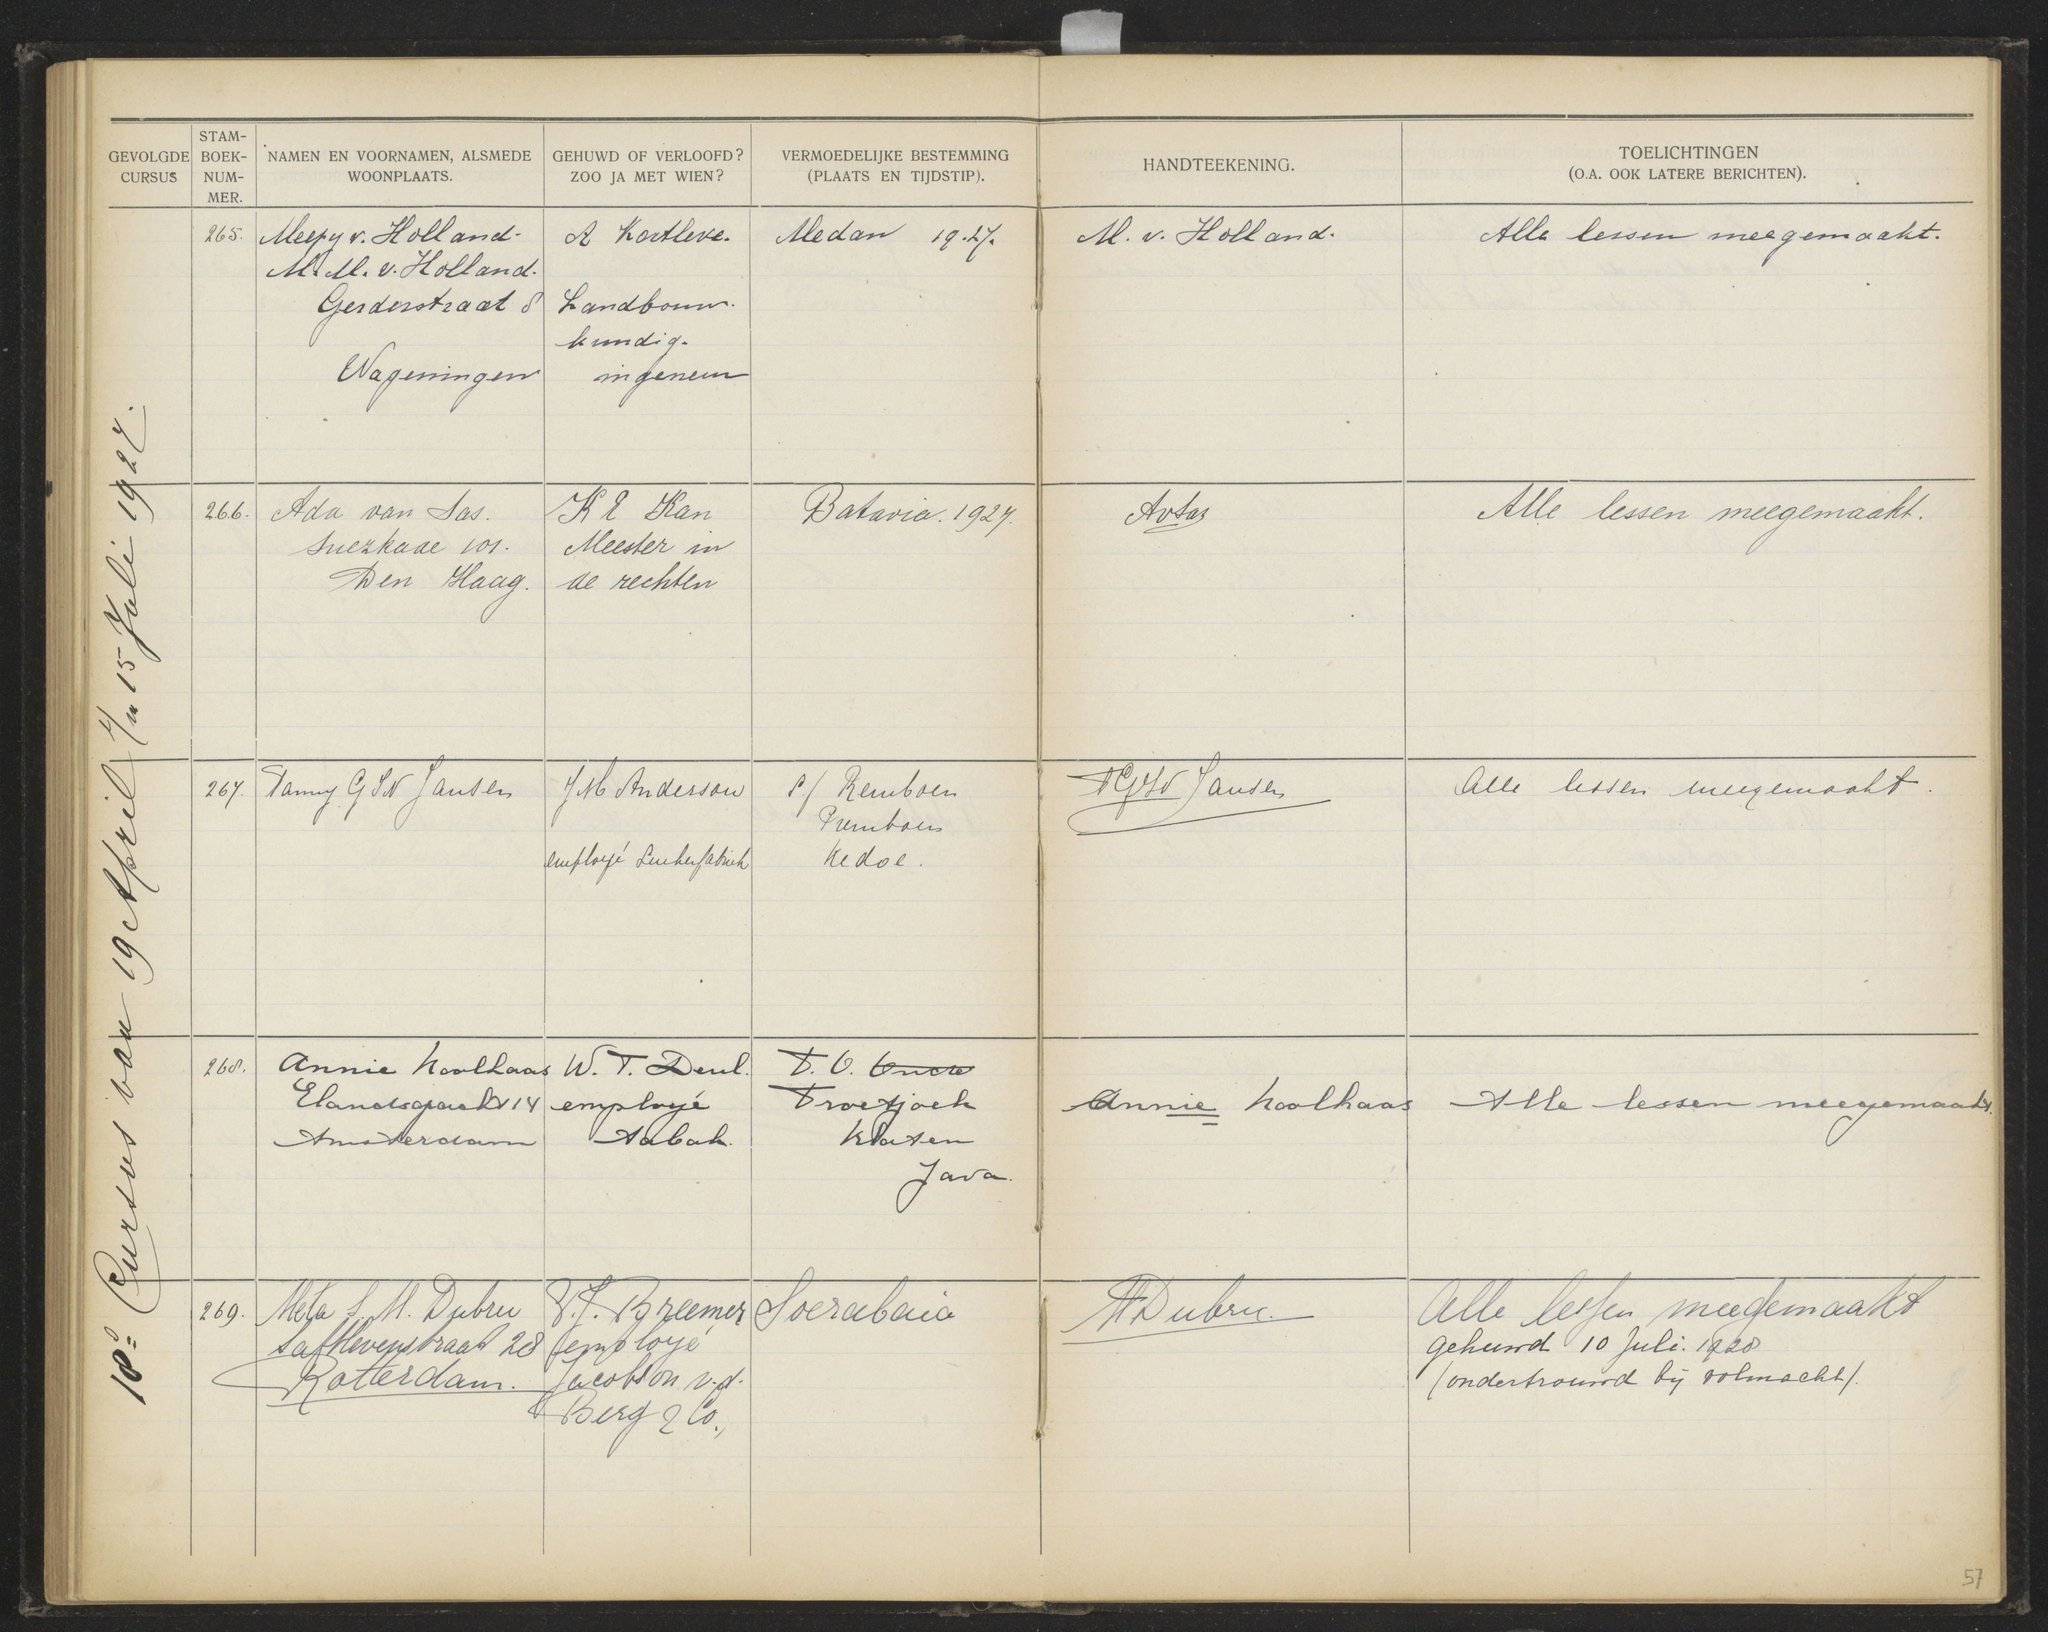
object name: album leaf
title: Blad 57 uit Stamboek van de leerlingen der Koloniale School voor Meisjes en Vrouwen te 's-Gravenhage deel I (1921-1929)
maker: Anonymous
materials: paper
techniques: printing, writing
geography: the hague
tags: further education (+ pupil), further education, the hague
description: Twee pagina's met gegevens van de deelnemers aan de 18e driemaandelijkse cursus van 19 april tot en met 15 juli 1927, stamboeknummers 265 tot en met 269. Onderdeel van Stamboek van de leerlingen der Koloniale School voor Meisjes en Vrouwen te 's-Gravenhage deel I (1921-1929).